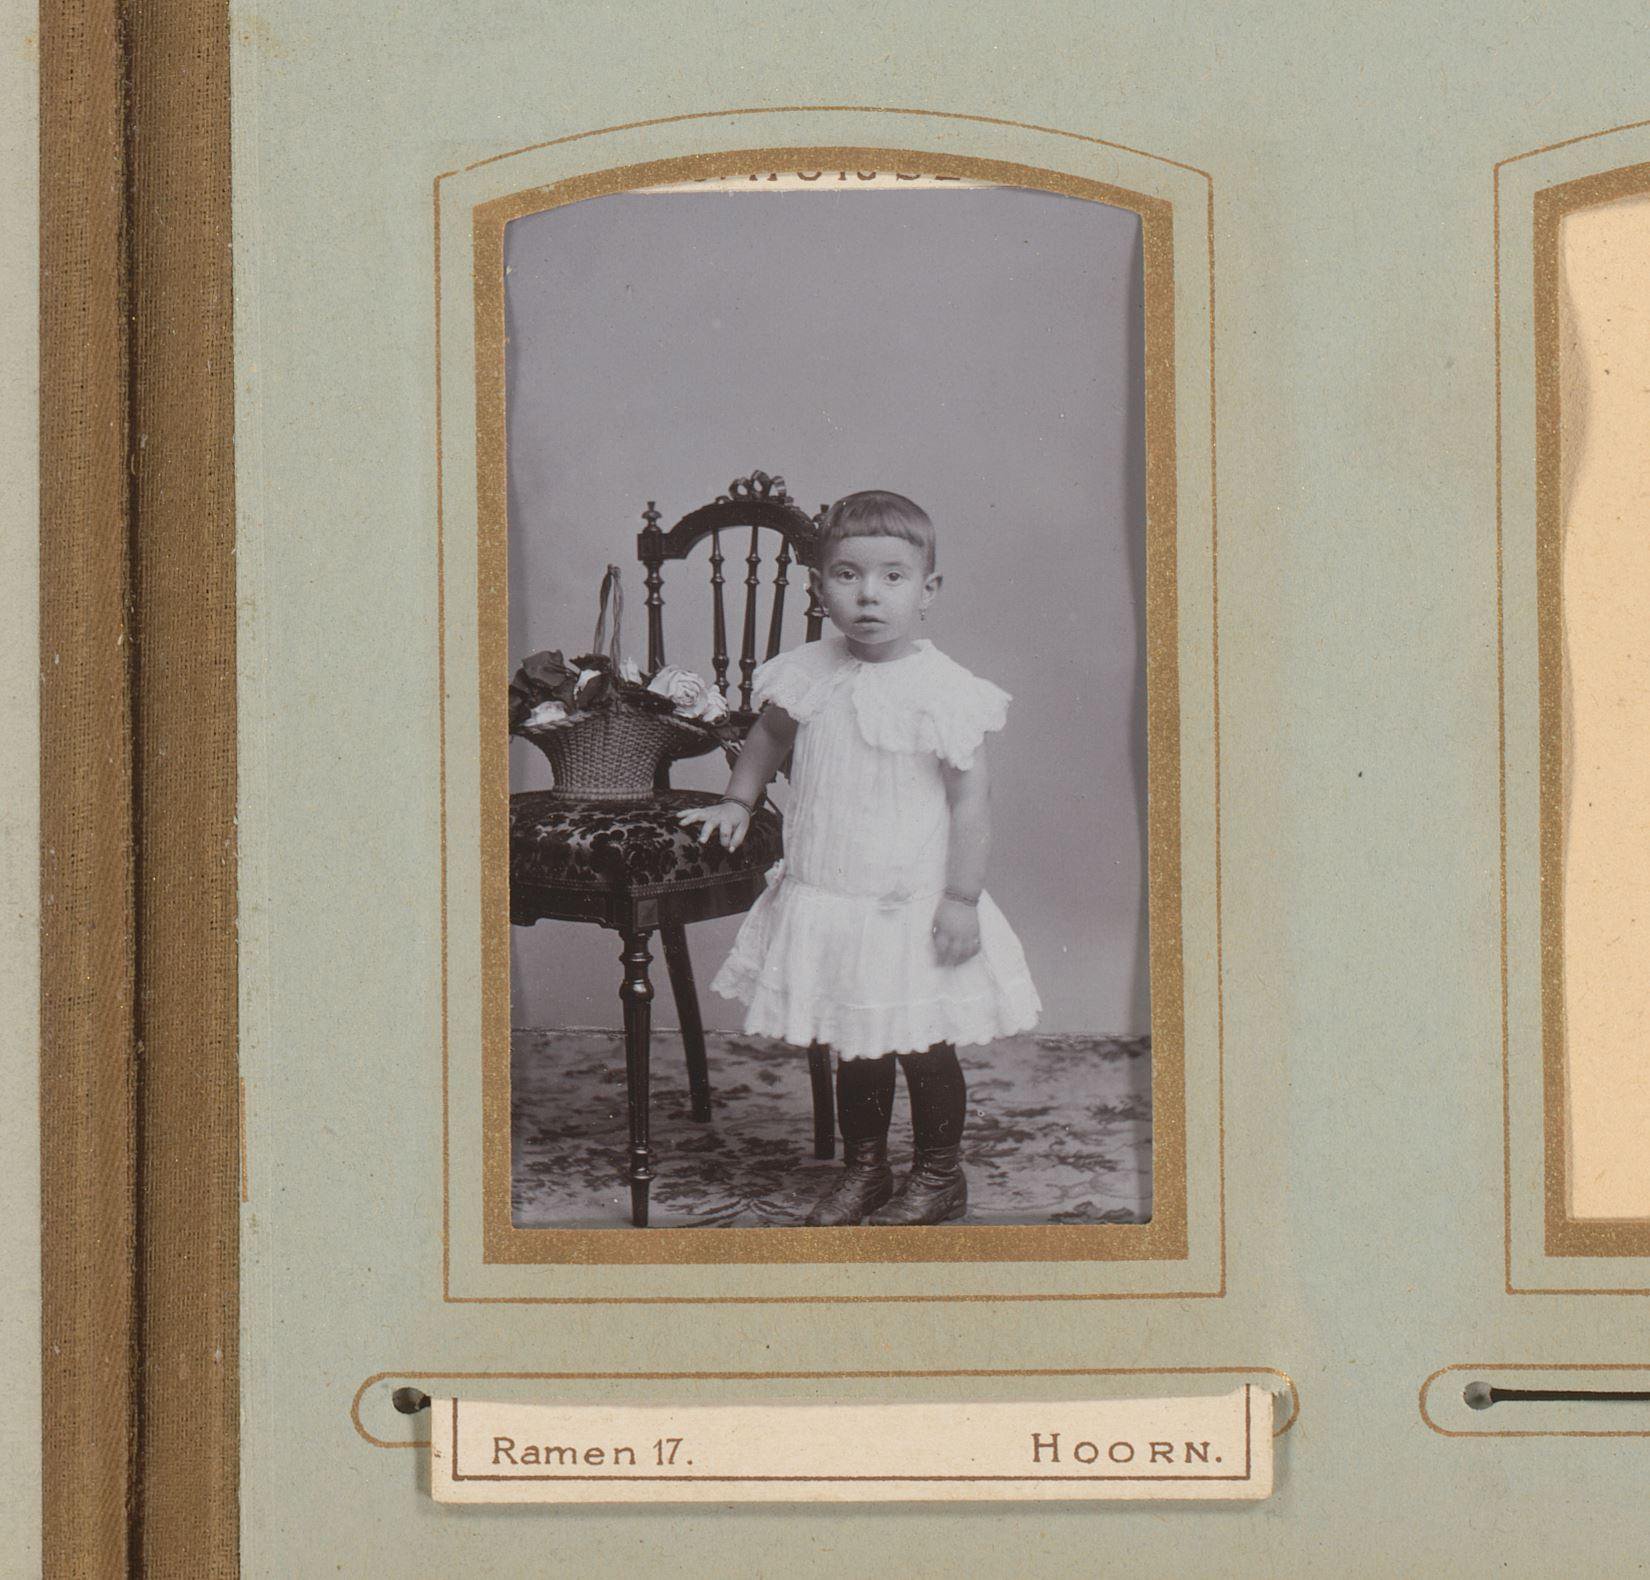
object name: photograph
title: Portret van een meisje, staand bij een stoel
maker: johannes laurens theodorus huijsen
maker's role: fotograaf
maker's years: 1852-1910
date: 1883-1910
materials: cardboard, photographic support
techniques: collodion silver print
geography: hoorn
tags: historical persons - bb - woman, toddler (female), chair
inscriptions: inscription: ‘J.L.T. HUIJSEN/ Photographe/ Bekroond op verschillende/ Tentoonstellingen/ HOORN/ Ramen 17./ De plaat blijft ter nabestelling bewaard.’